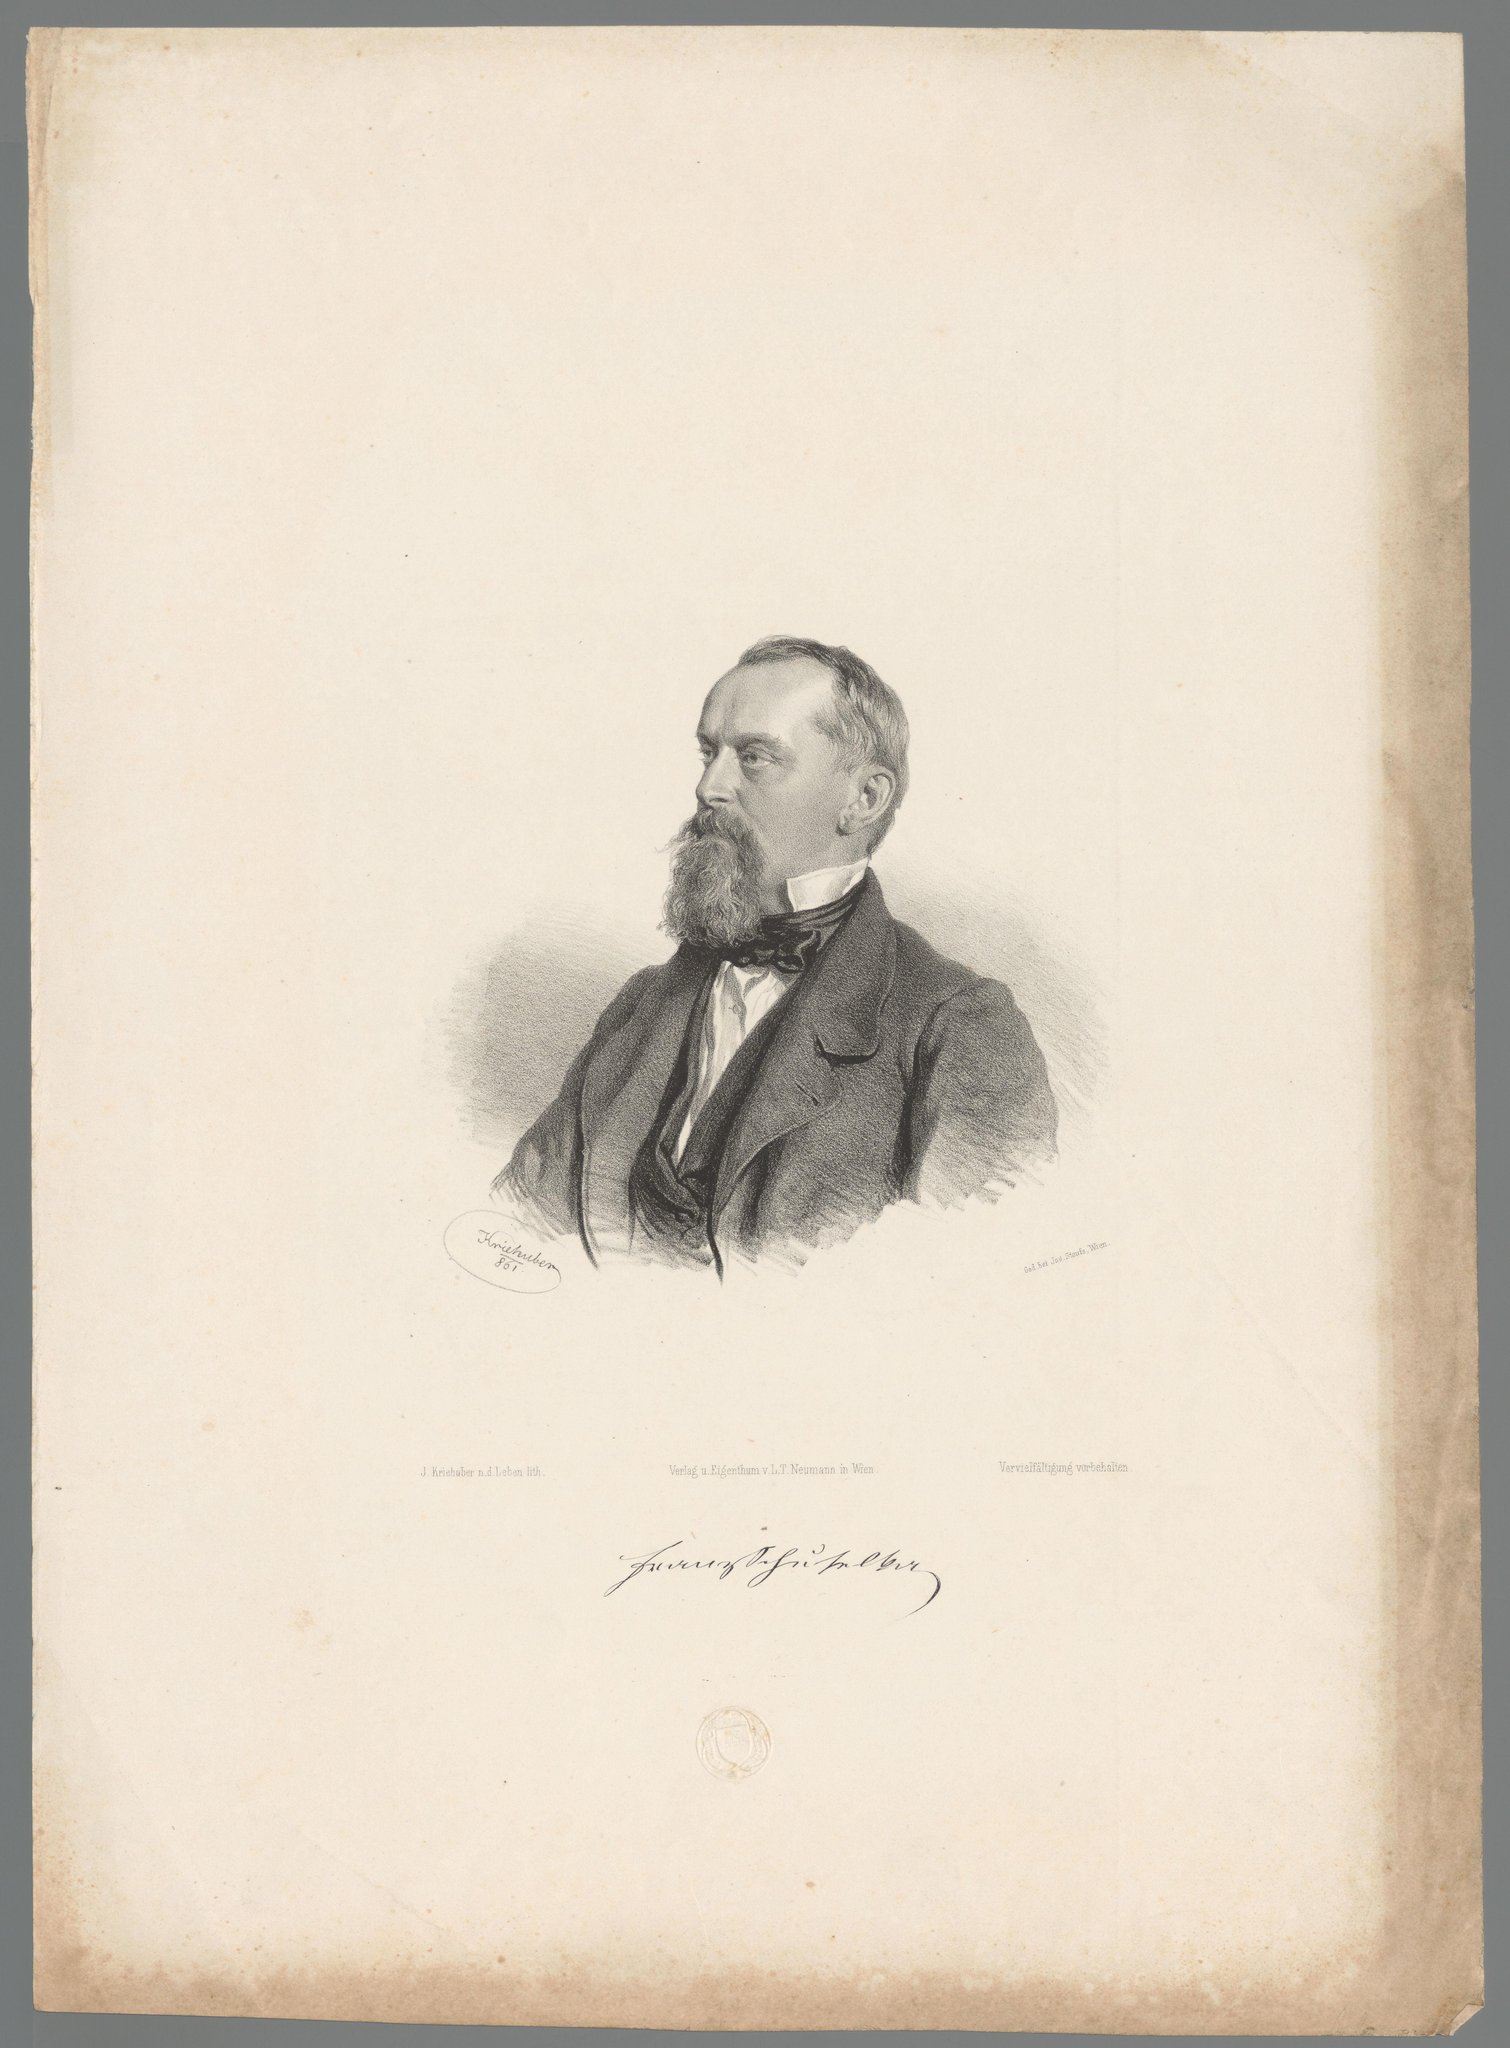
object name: print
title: Portret van Franz Schuselka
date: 1861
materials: paper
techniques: lithograph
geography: vienna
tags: politician, historical persons, politician, e.g. party leader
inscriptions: collector's mark: Lugt 2228, check stamp: ‘Kunsthandlung L.T. Neumann in Wien’